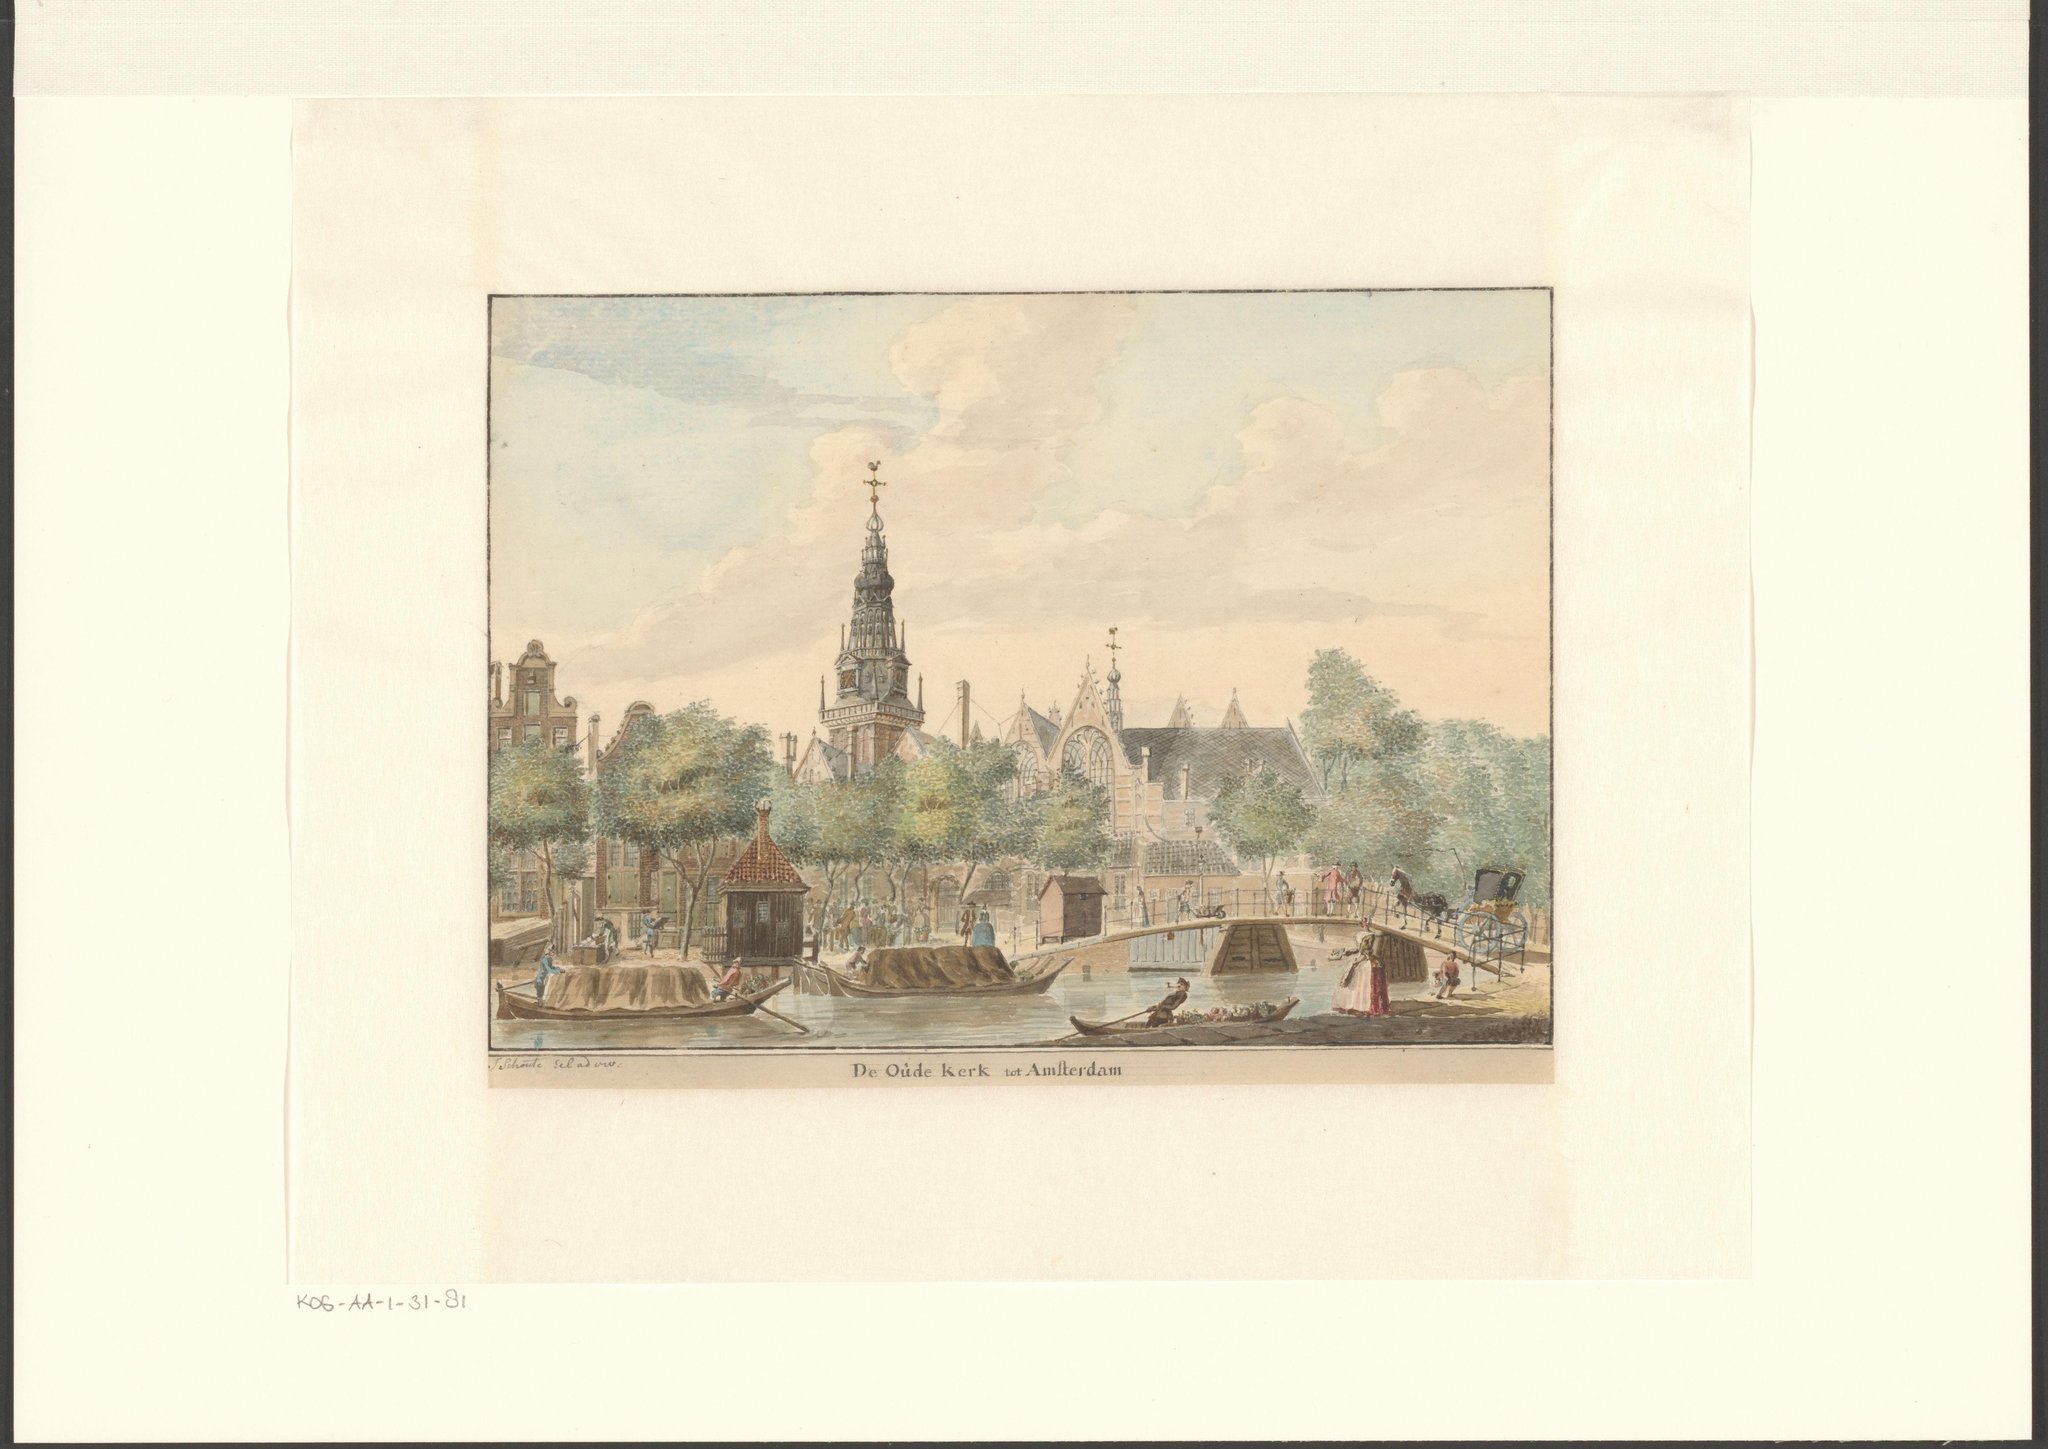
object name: drawing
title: Gezicht op de Oude Kerk vanaf de Oudezijds Voorburgwal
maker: johannes schouten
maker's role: print maker, silversmith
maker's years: 1716-1792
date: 1726-1792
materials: ink, paper, pencil, watercolor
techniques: brush, pen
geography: amsterdam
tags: tower, clock tower ~ monumental adornment, city-view in general; 'veduta', canal, church (exterior), bridge in city across river, canal, etc., boat propelled by man or animal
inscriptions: signature: ‘J Schoute del ad viv:’, inscription: ‘De Oude Kerk tot Amsterdam’, inscription: ‘31.81’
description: Onderwerpsrubriek binnen de Atlas Amsterdam: Oude Kerk van buiten.